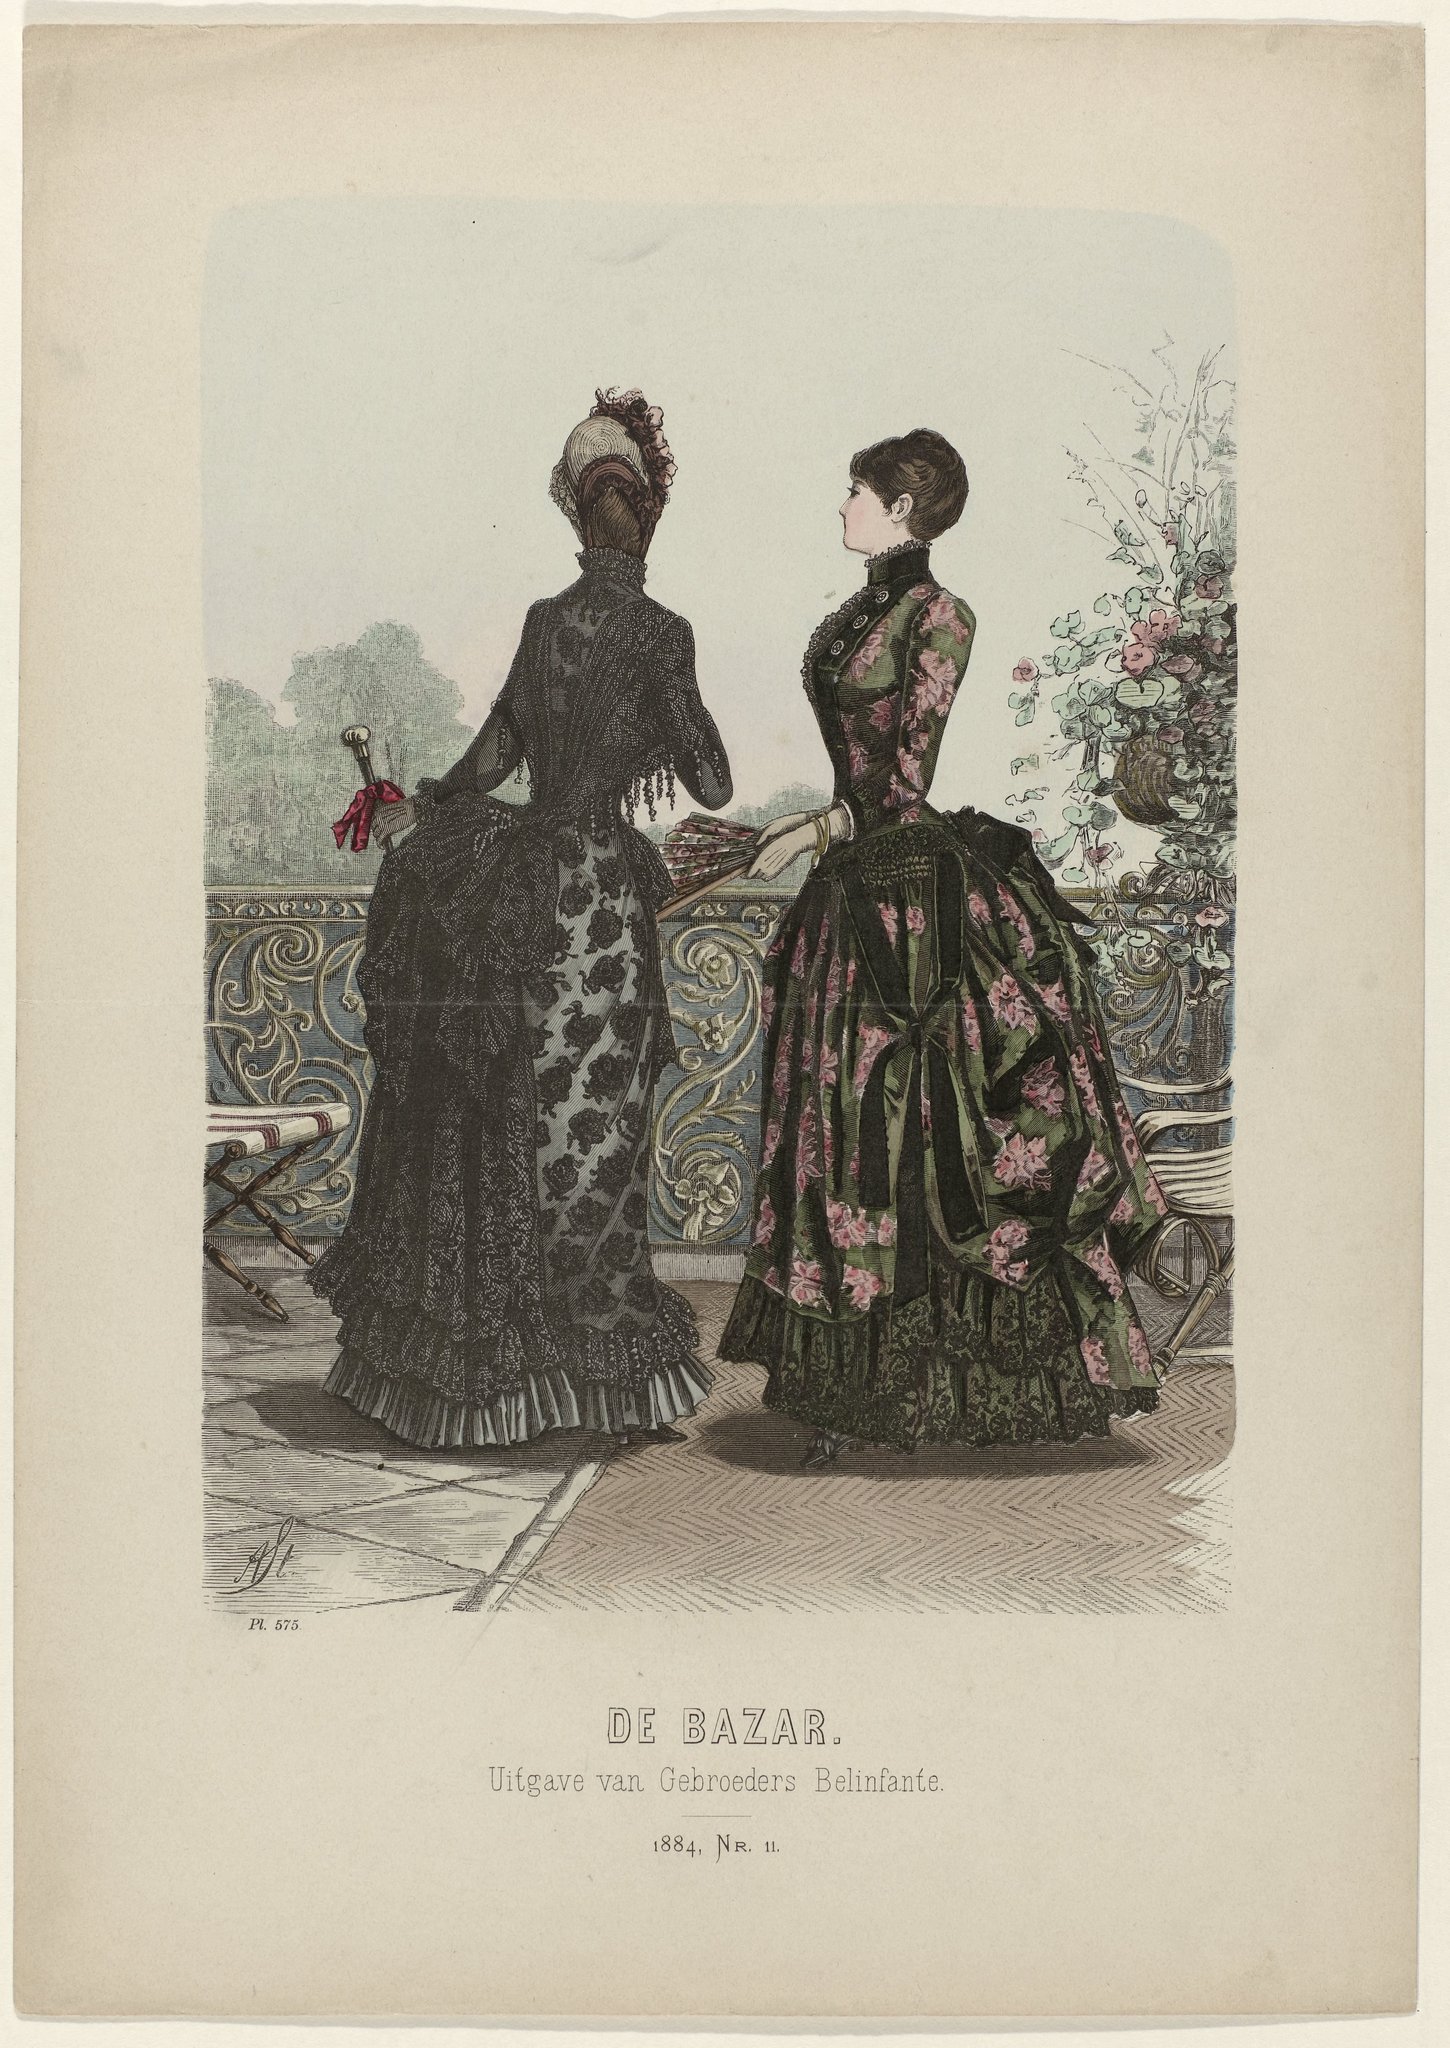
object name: fashion print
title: De Bazar, 1884, Nr. 11, Pl. 575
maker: Anonymous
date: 1884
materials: paper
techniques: hand coloring, engraving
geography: the hague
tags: walking-stick, staff, cane (+ women's clothes), fashion plates, head-gear: hat (+ women's clothes), dress, gown (+ women's clothes), balustrade, bracelet, wristlet (+ women's clothes)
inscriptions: caption: ‘DE BAZAR. / Uitgave van Gebroeders Belinfante. / 1884, Nr. 11’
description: Prent uit het modetijdschrift De Bazar, geïllustreerd Tijdschrift voor Modes en Handwerken (1857-1900).